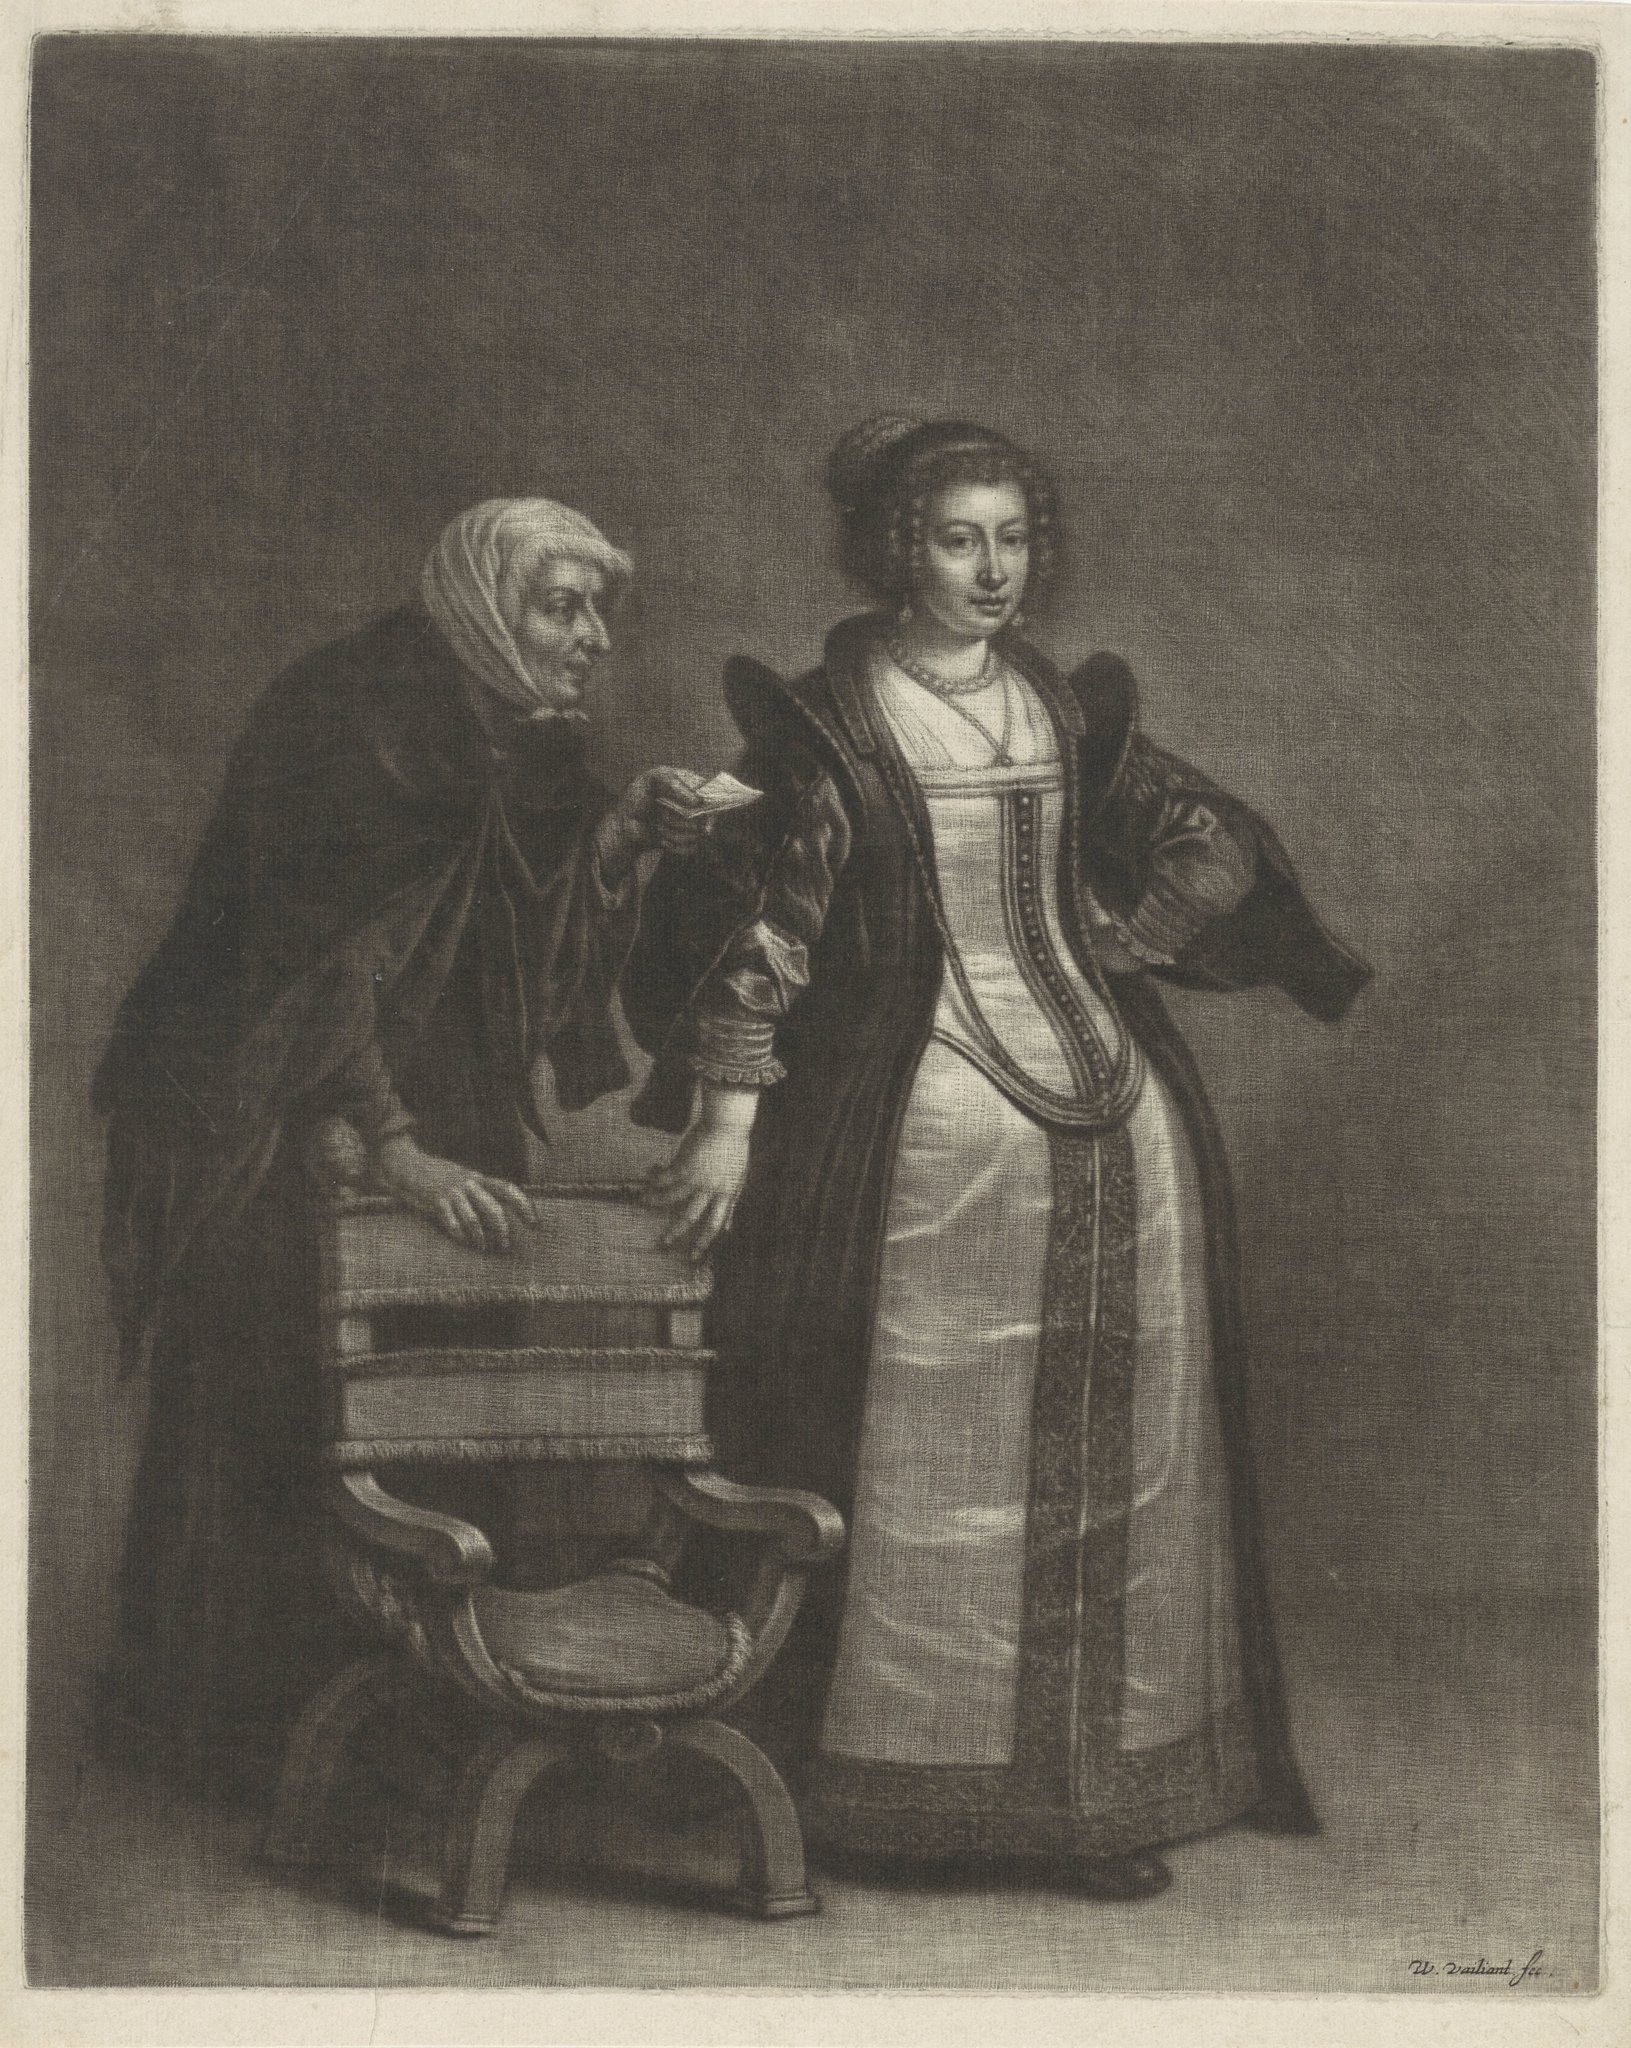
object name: print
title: Overhandiging van een brief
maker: wallerant vaillant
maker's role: draughtsman, painter, print maker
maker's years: 1623-1677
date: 1658-1677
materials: paper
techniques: mezzotint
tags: letter, envelope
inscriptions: collector's mark: Lugt 2228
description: Een oude vrouw steunt op een stoel en overhandigt een brief aan een jonge vrouw, die dezelfde stoel vasthoudt.